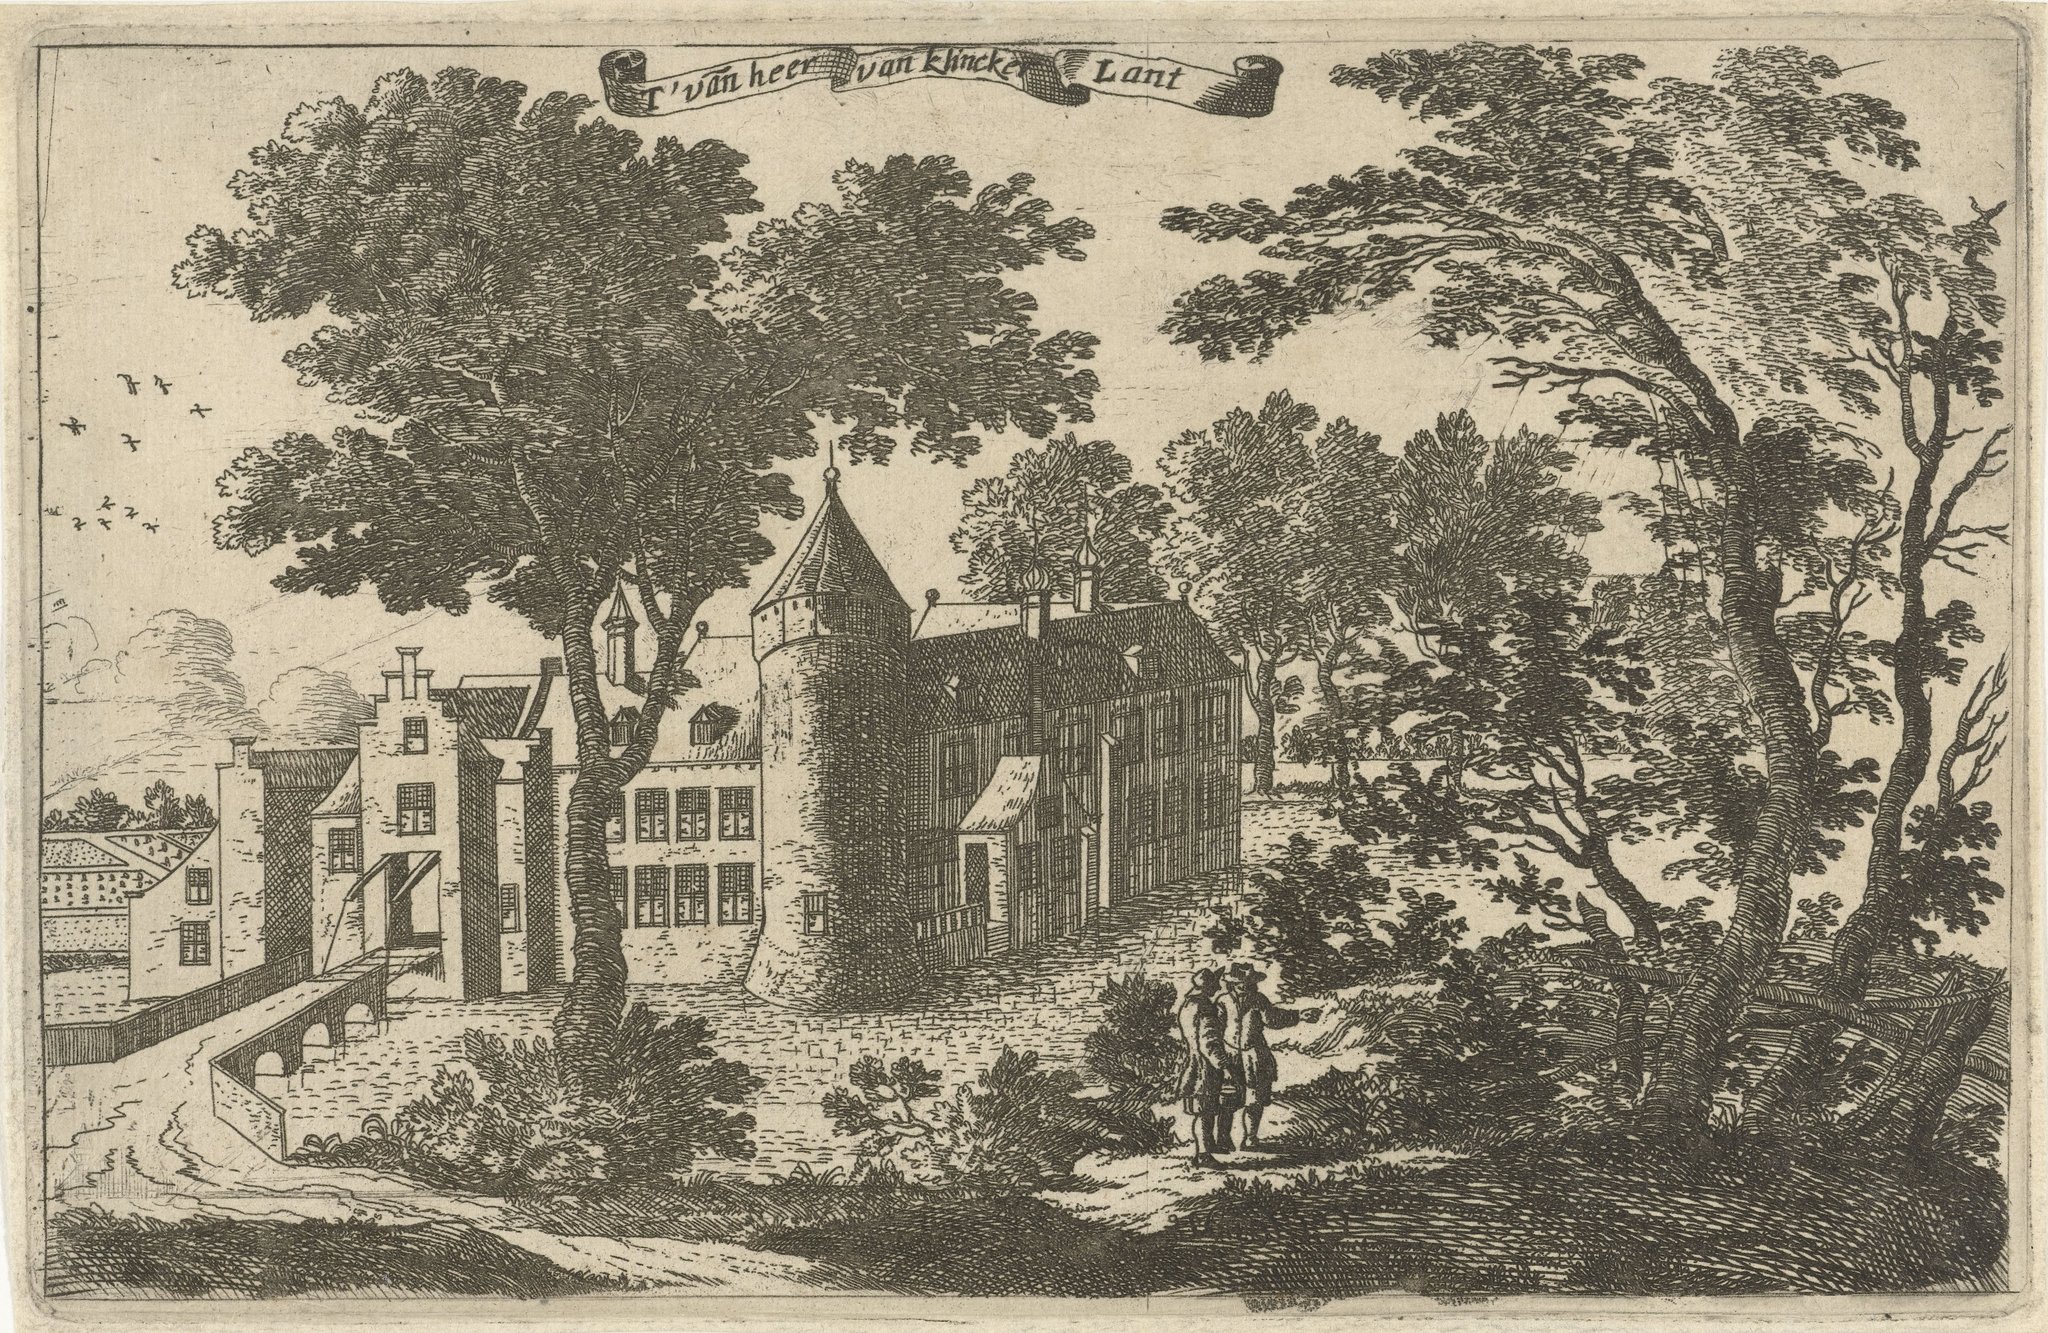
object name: print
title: Gezicht op Huis te Blotinghe te Rijswijk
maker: cornelis elandts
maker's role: draughtsman, painter, print maker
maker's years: 1641-1687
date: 1663-1670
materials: paper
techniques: etching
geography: the hague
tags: castle, landscape with tower or castle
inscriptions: collector's mark: Lugt 2228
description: Gezicht op Huis te Blotinghe te Rijswijk. Op de voorgrond, bij een boompartij, staan twee mannen met elkaar te praten. In de lucht een banderol met de titel van de prent. Dit kasteel werd tussen 1590 en 1715 bewoond door leden van de familie De Nobelaer, waarvan sommige telgen de titel heer van Klinkerland droegen.